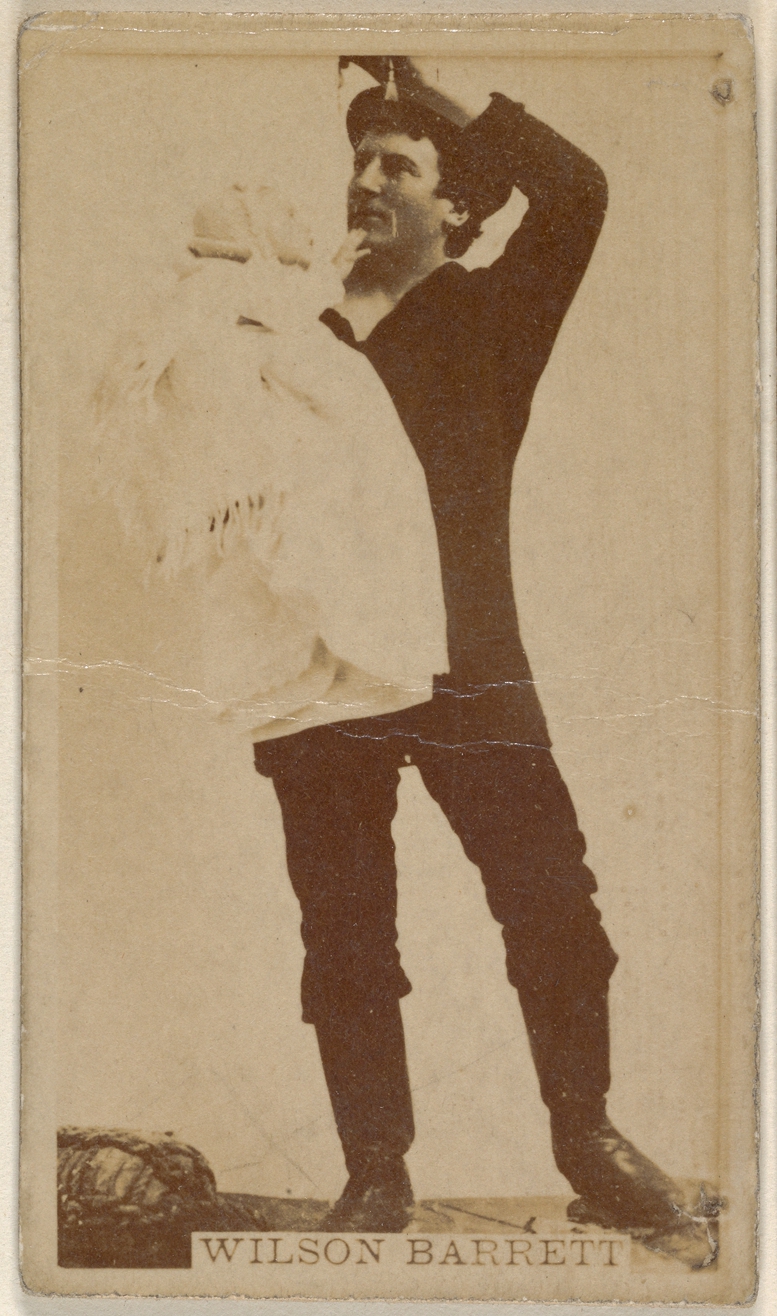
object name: photograph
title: Wilson Barrett, from the Actors and Actresses series (N45, Type 8) for Virginia Brights Cigarettes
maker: allen & ginter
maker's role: publisher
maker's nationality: american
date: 1888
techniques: albumen silver print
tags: infants,men,portraits,actors